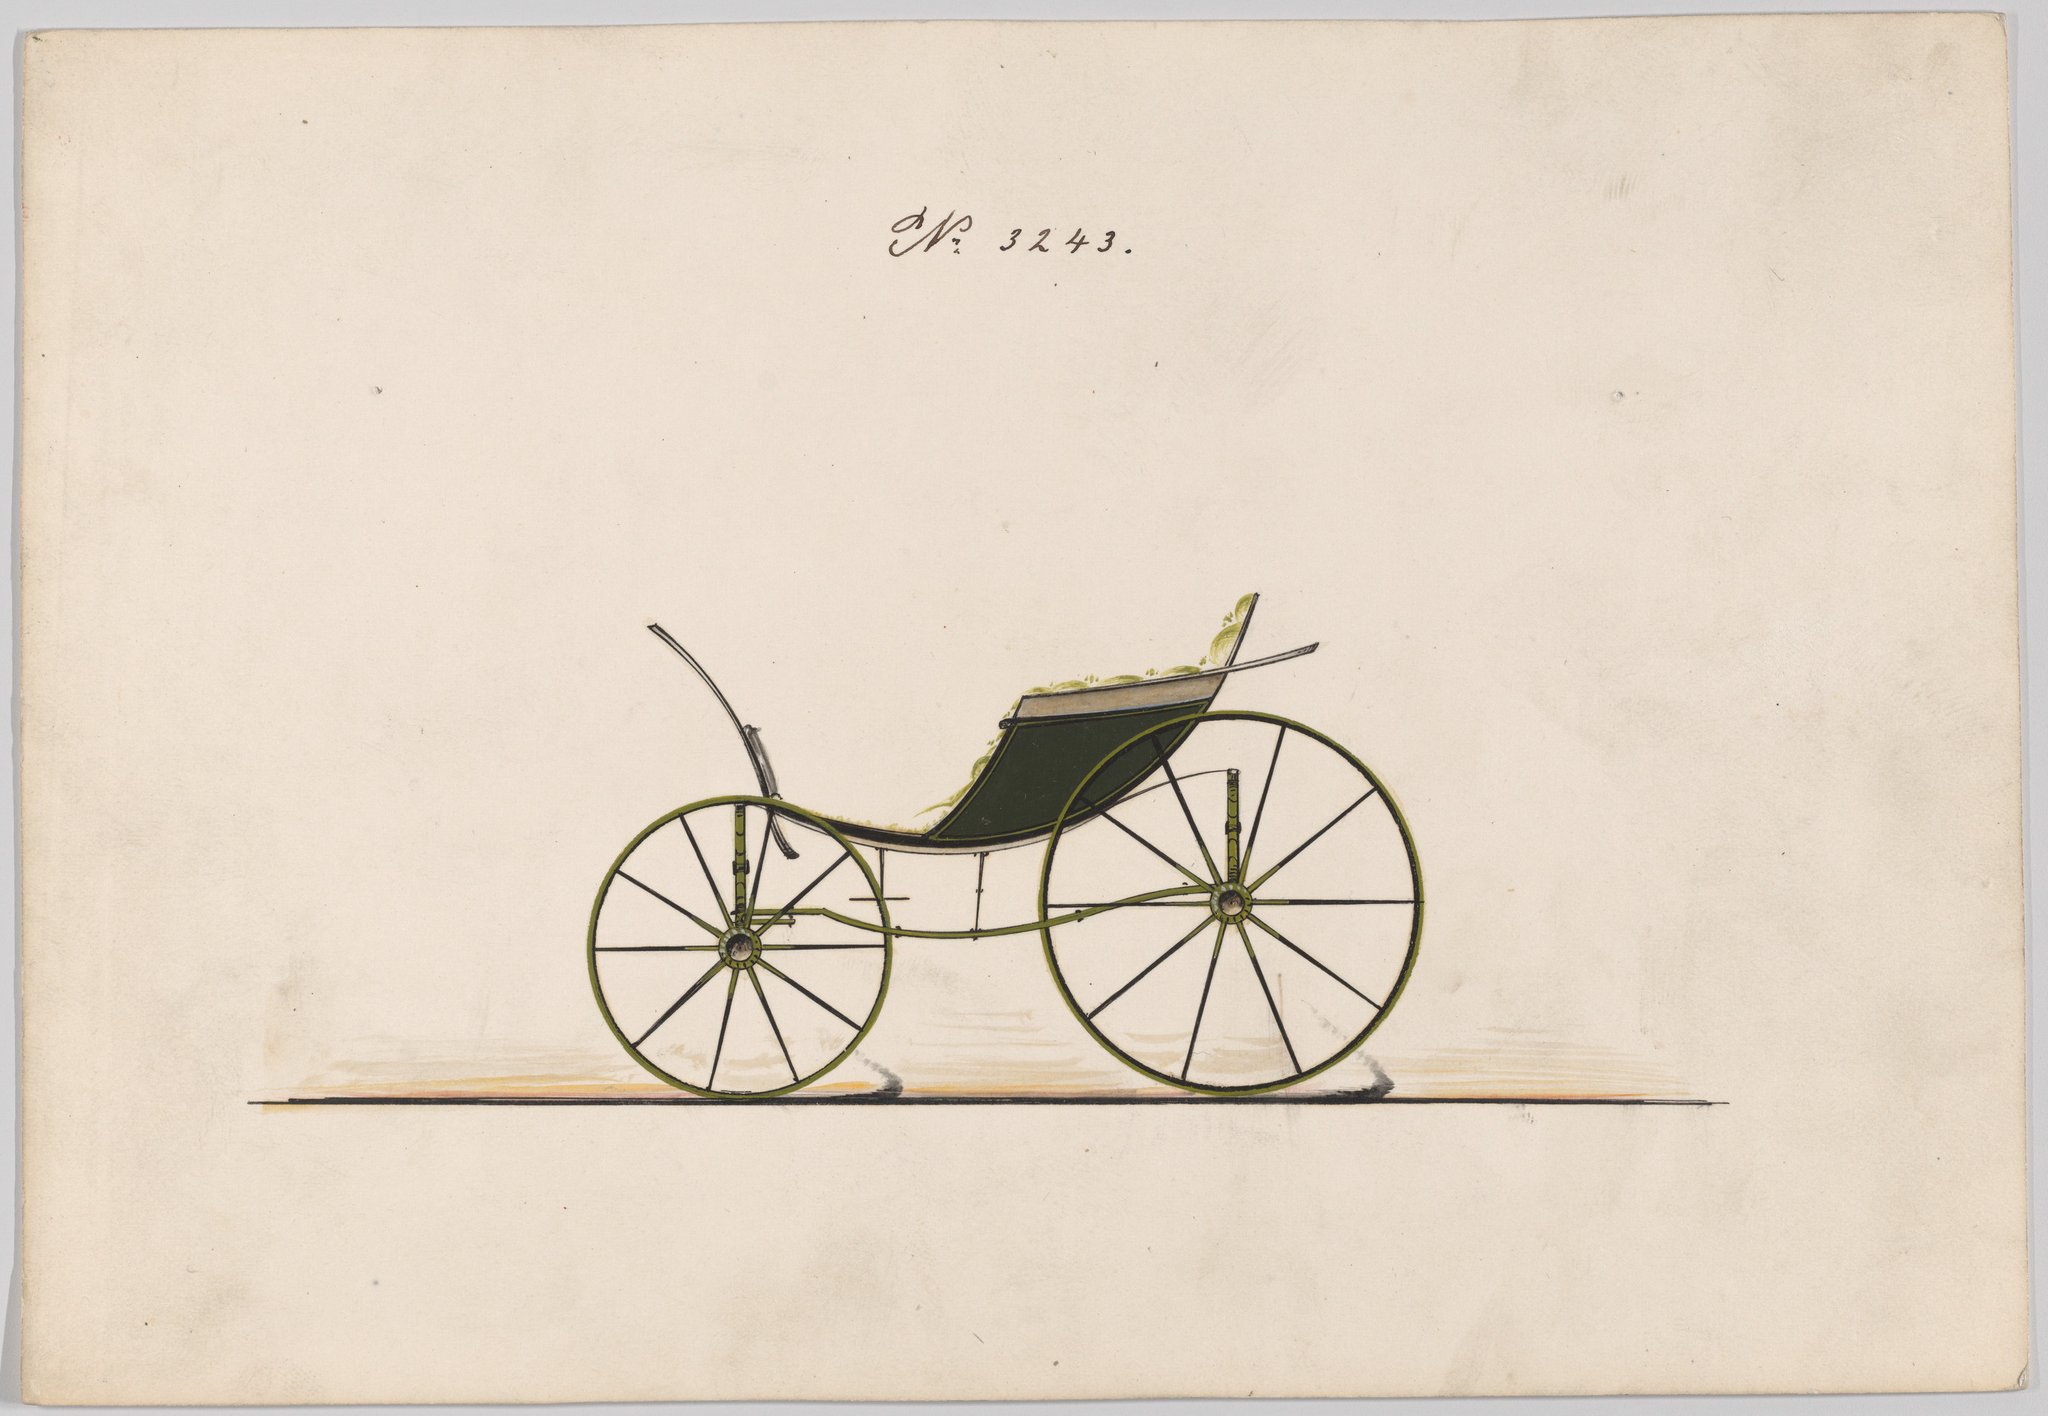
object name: drawing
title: Design for Pony Phaeton, no. 3243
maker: brewster & co.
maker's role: manufacturer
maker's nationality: american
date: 1876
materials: gouache, gum arabic, ink, watercolor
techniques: pen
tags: carriages